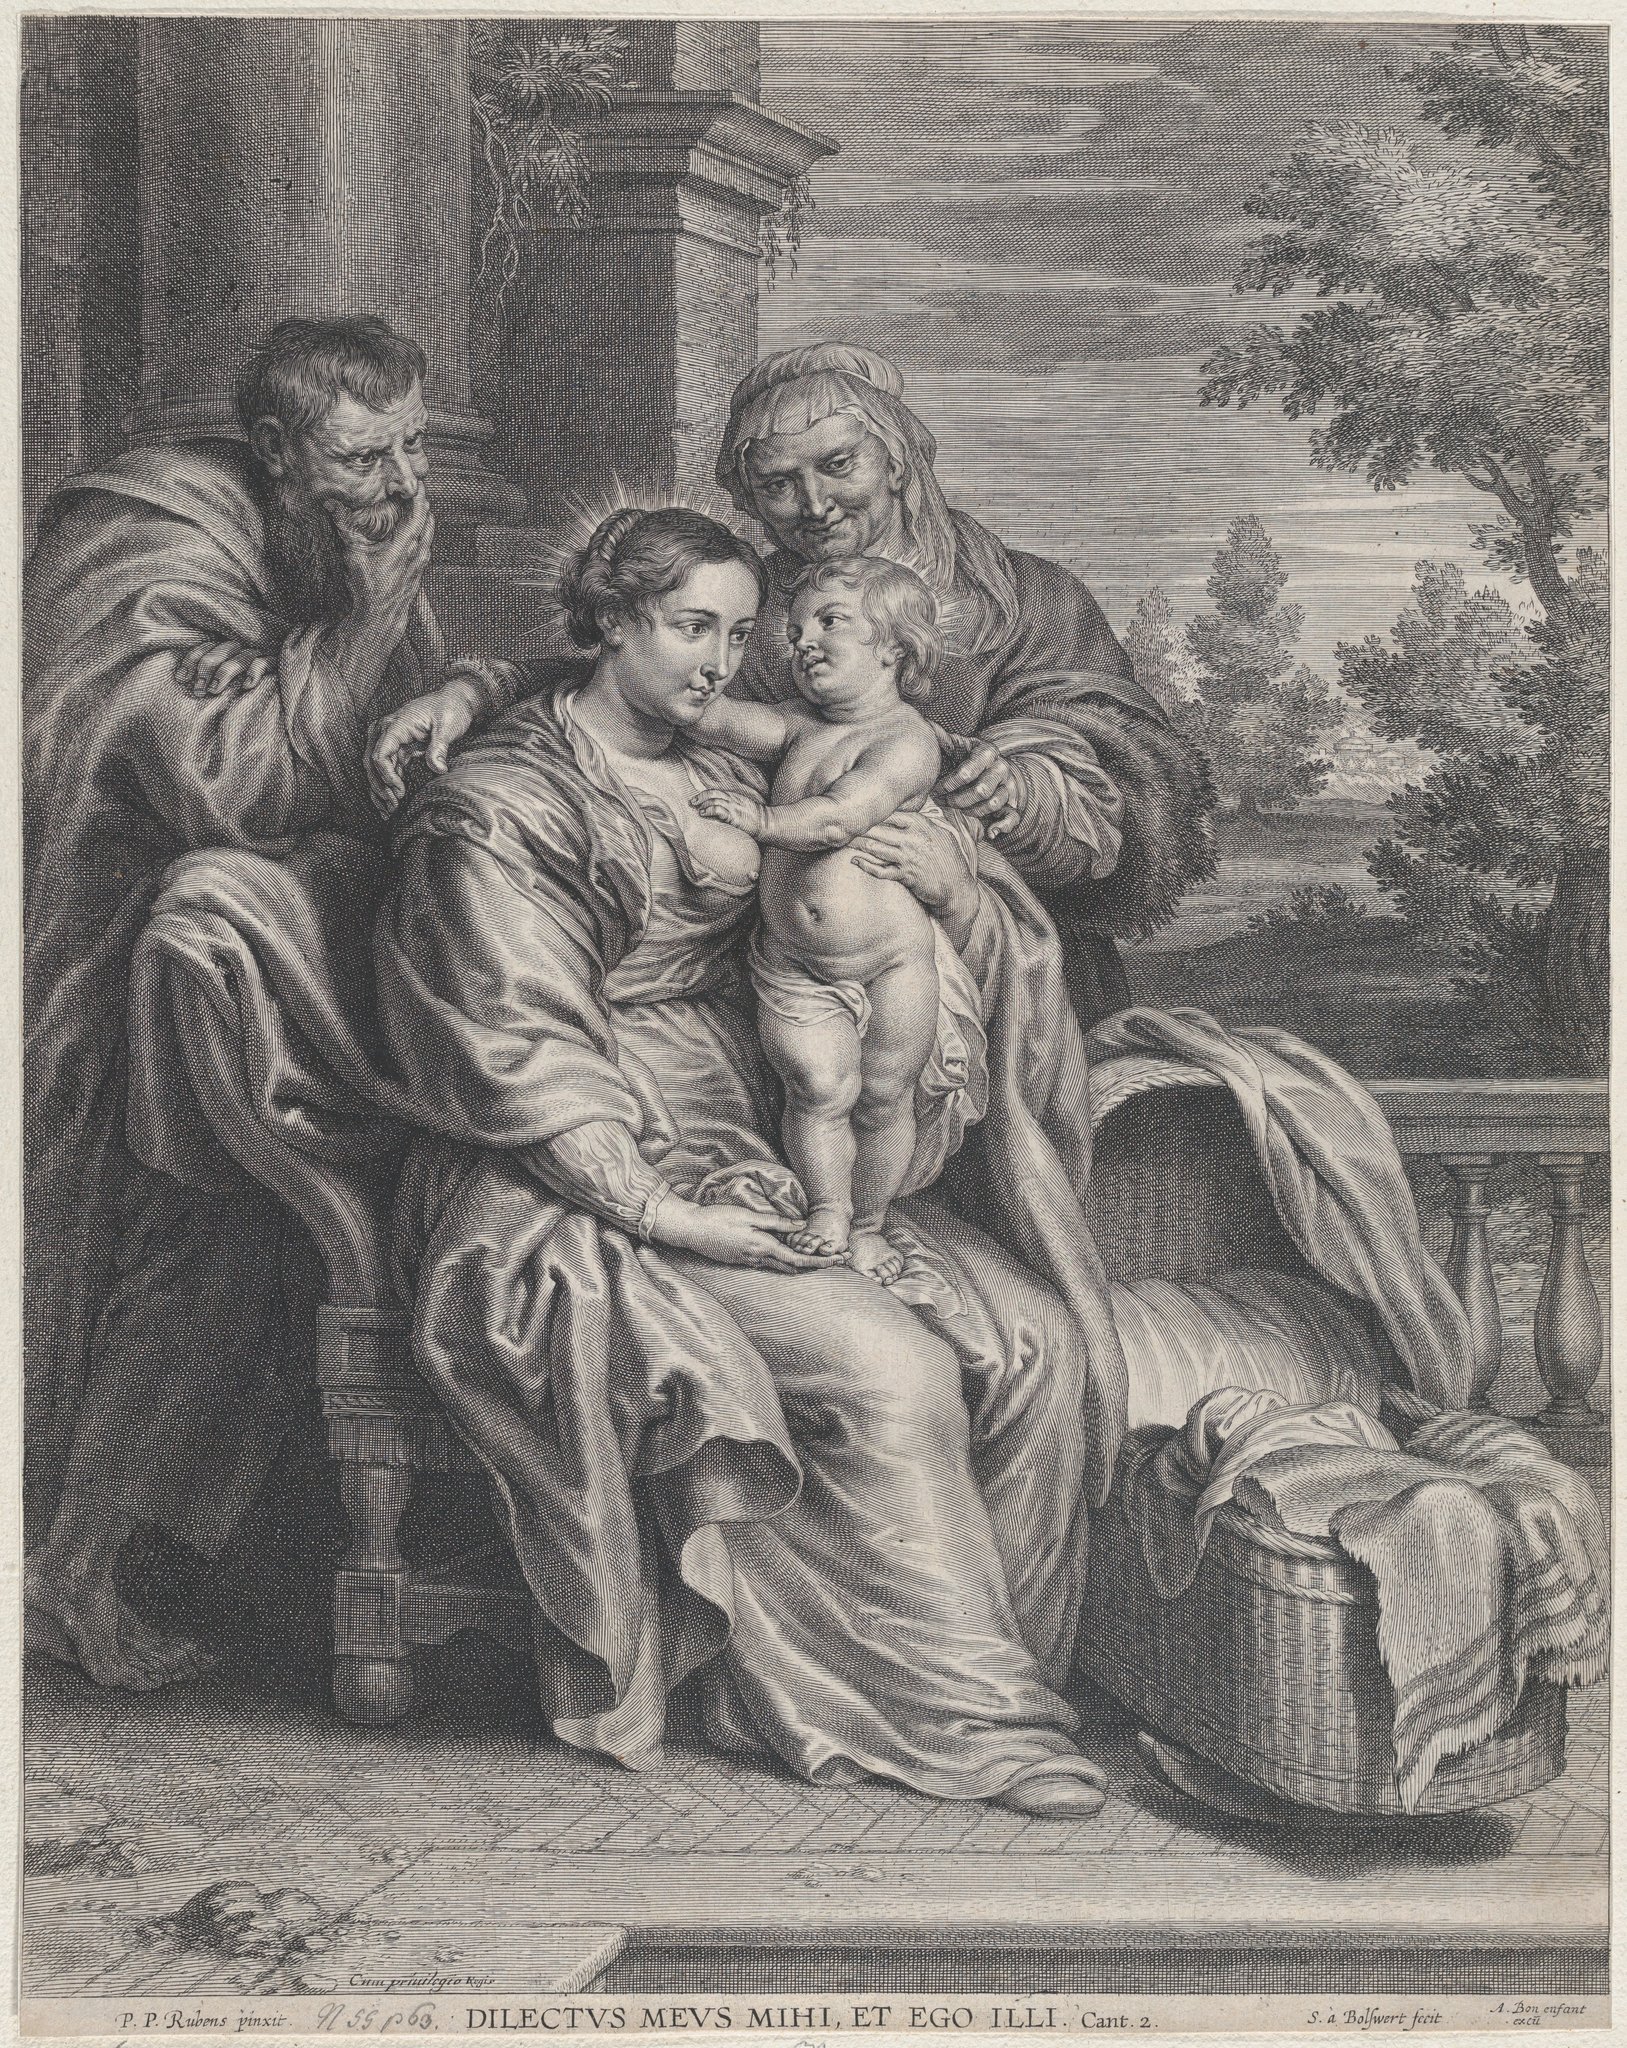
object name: print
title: The Holy Family with Saint Anne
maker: schelte adams à bolswert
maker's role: artist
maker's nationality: dutch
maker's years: 1581-1659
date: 1625-1635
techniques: engraving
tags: holy family,saint anne